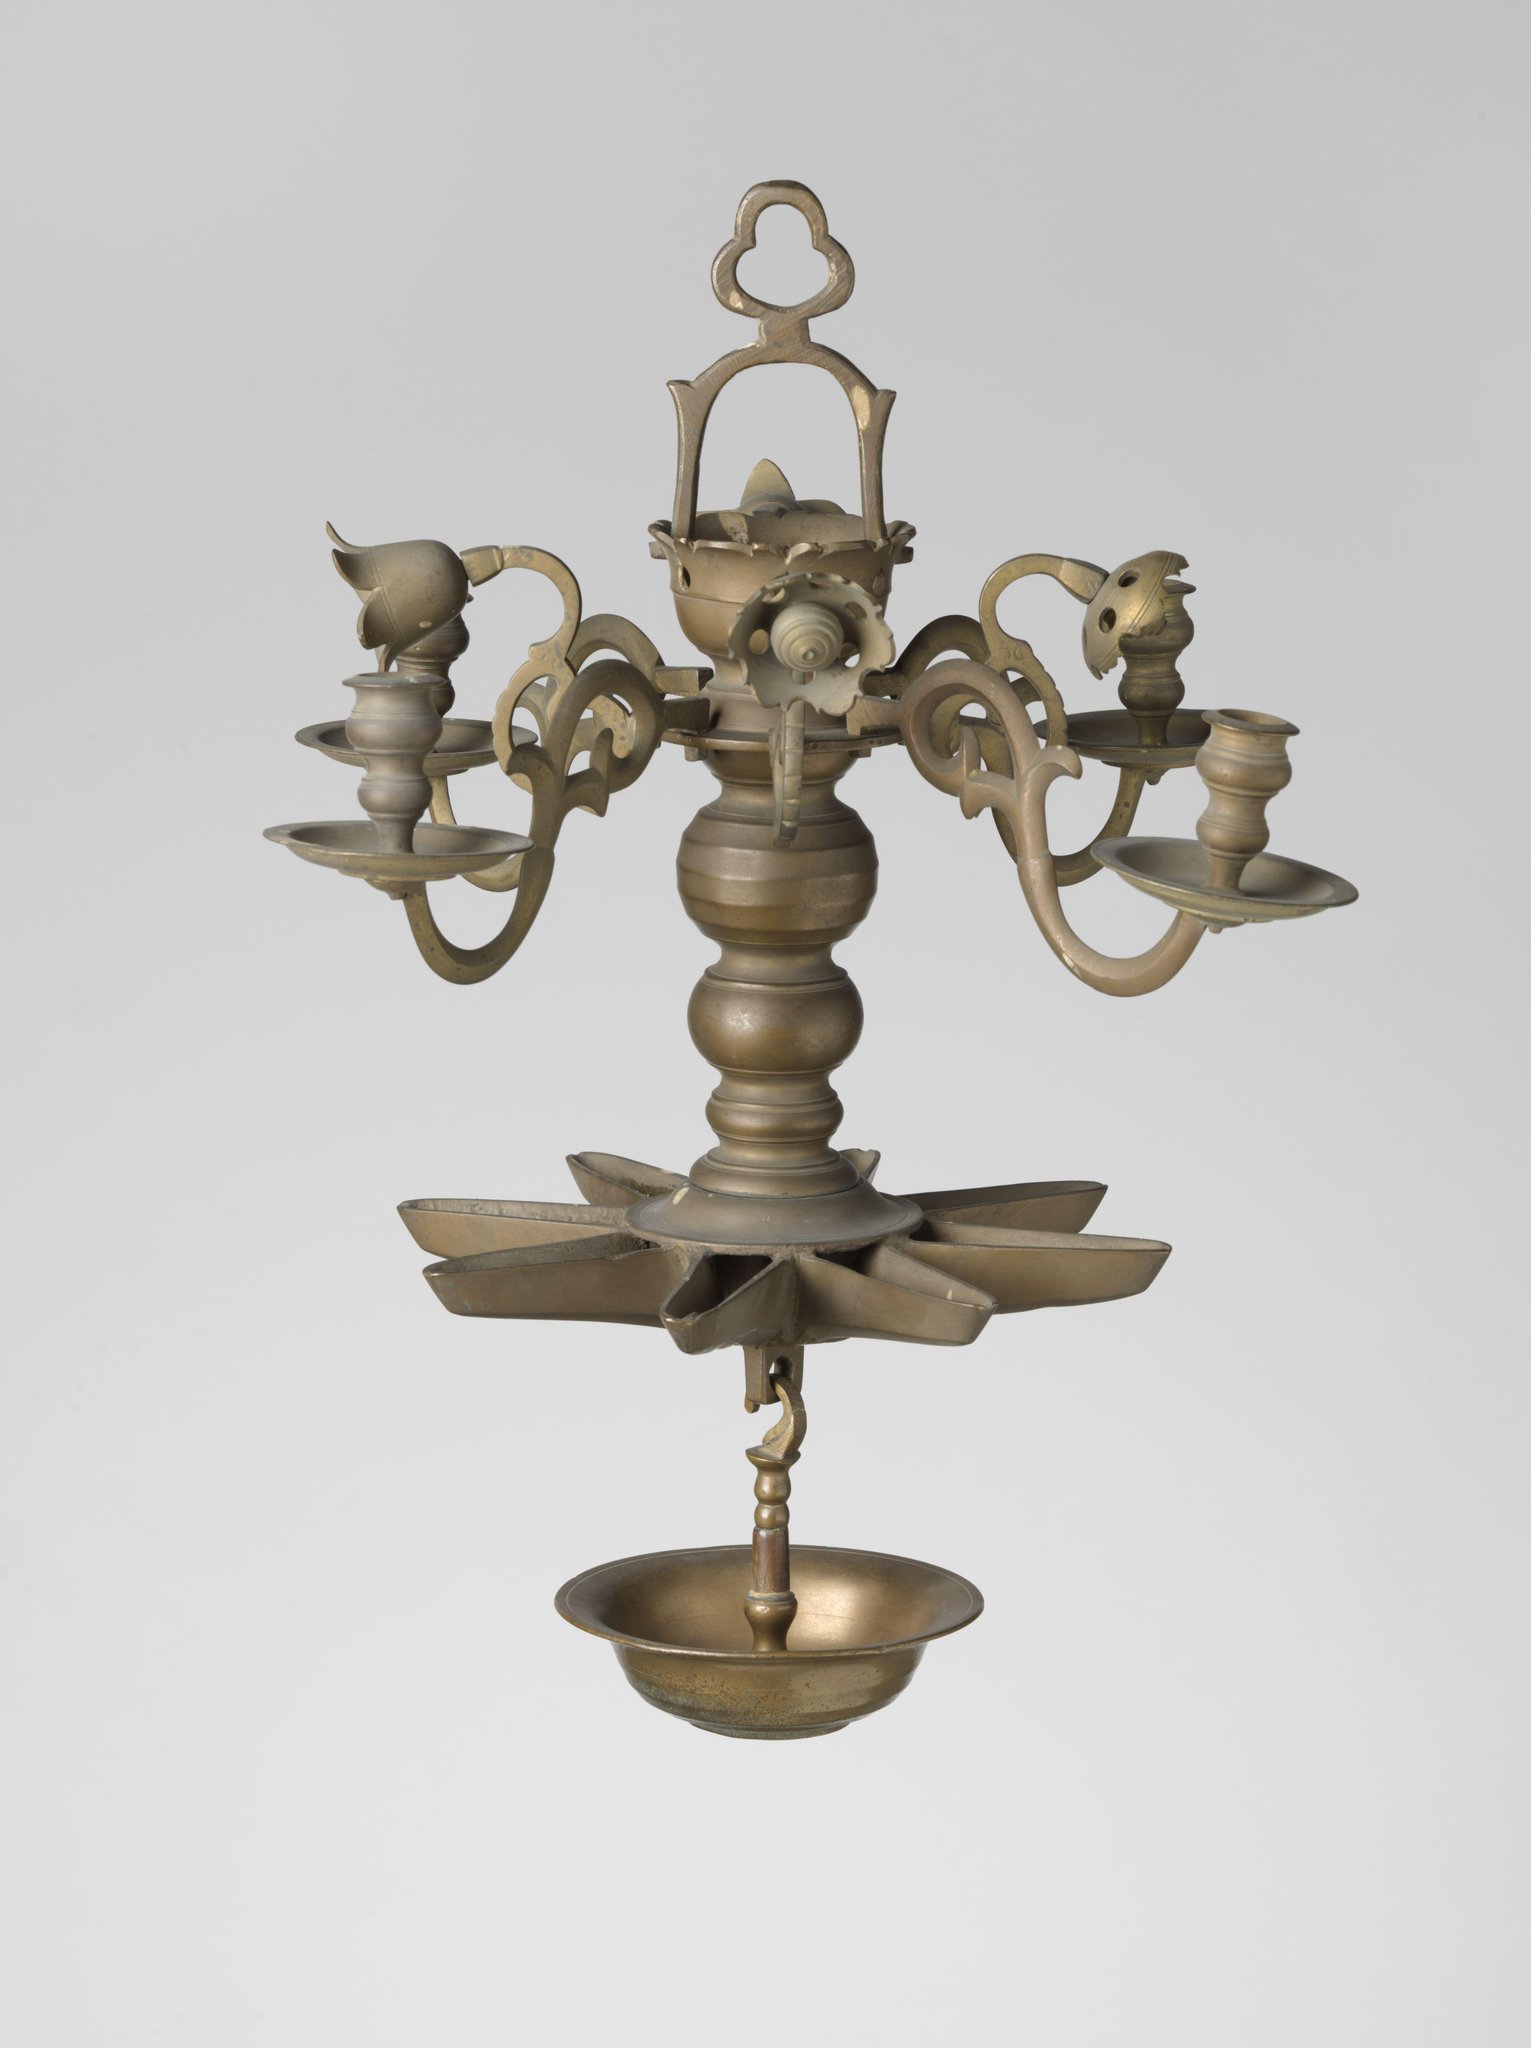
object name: sabbath lamp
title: Sierelement van sabbathlamp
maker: Anonymous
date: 1700-1800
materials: brass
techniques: casting, screwed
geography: nuremberg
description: Sierarm van een sabbathlamp. De S-vormige arm eindigt naar de stam toe in een krul. Naar buiten toe gaat deze over in breder deel, waarin de brede opengewerkte bloem met een grote, ronde geprofileerde kern is geschroefd. Dit is de derde arm, genummerd met 3 ronde punten.